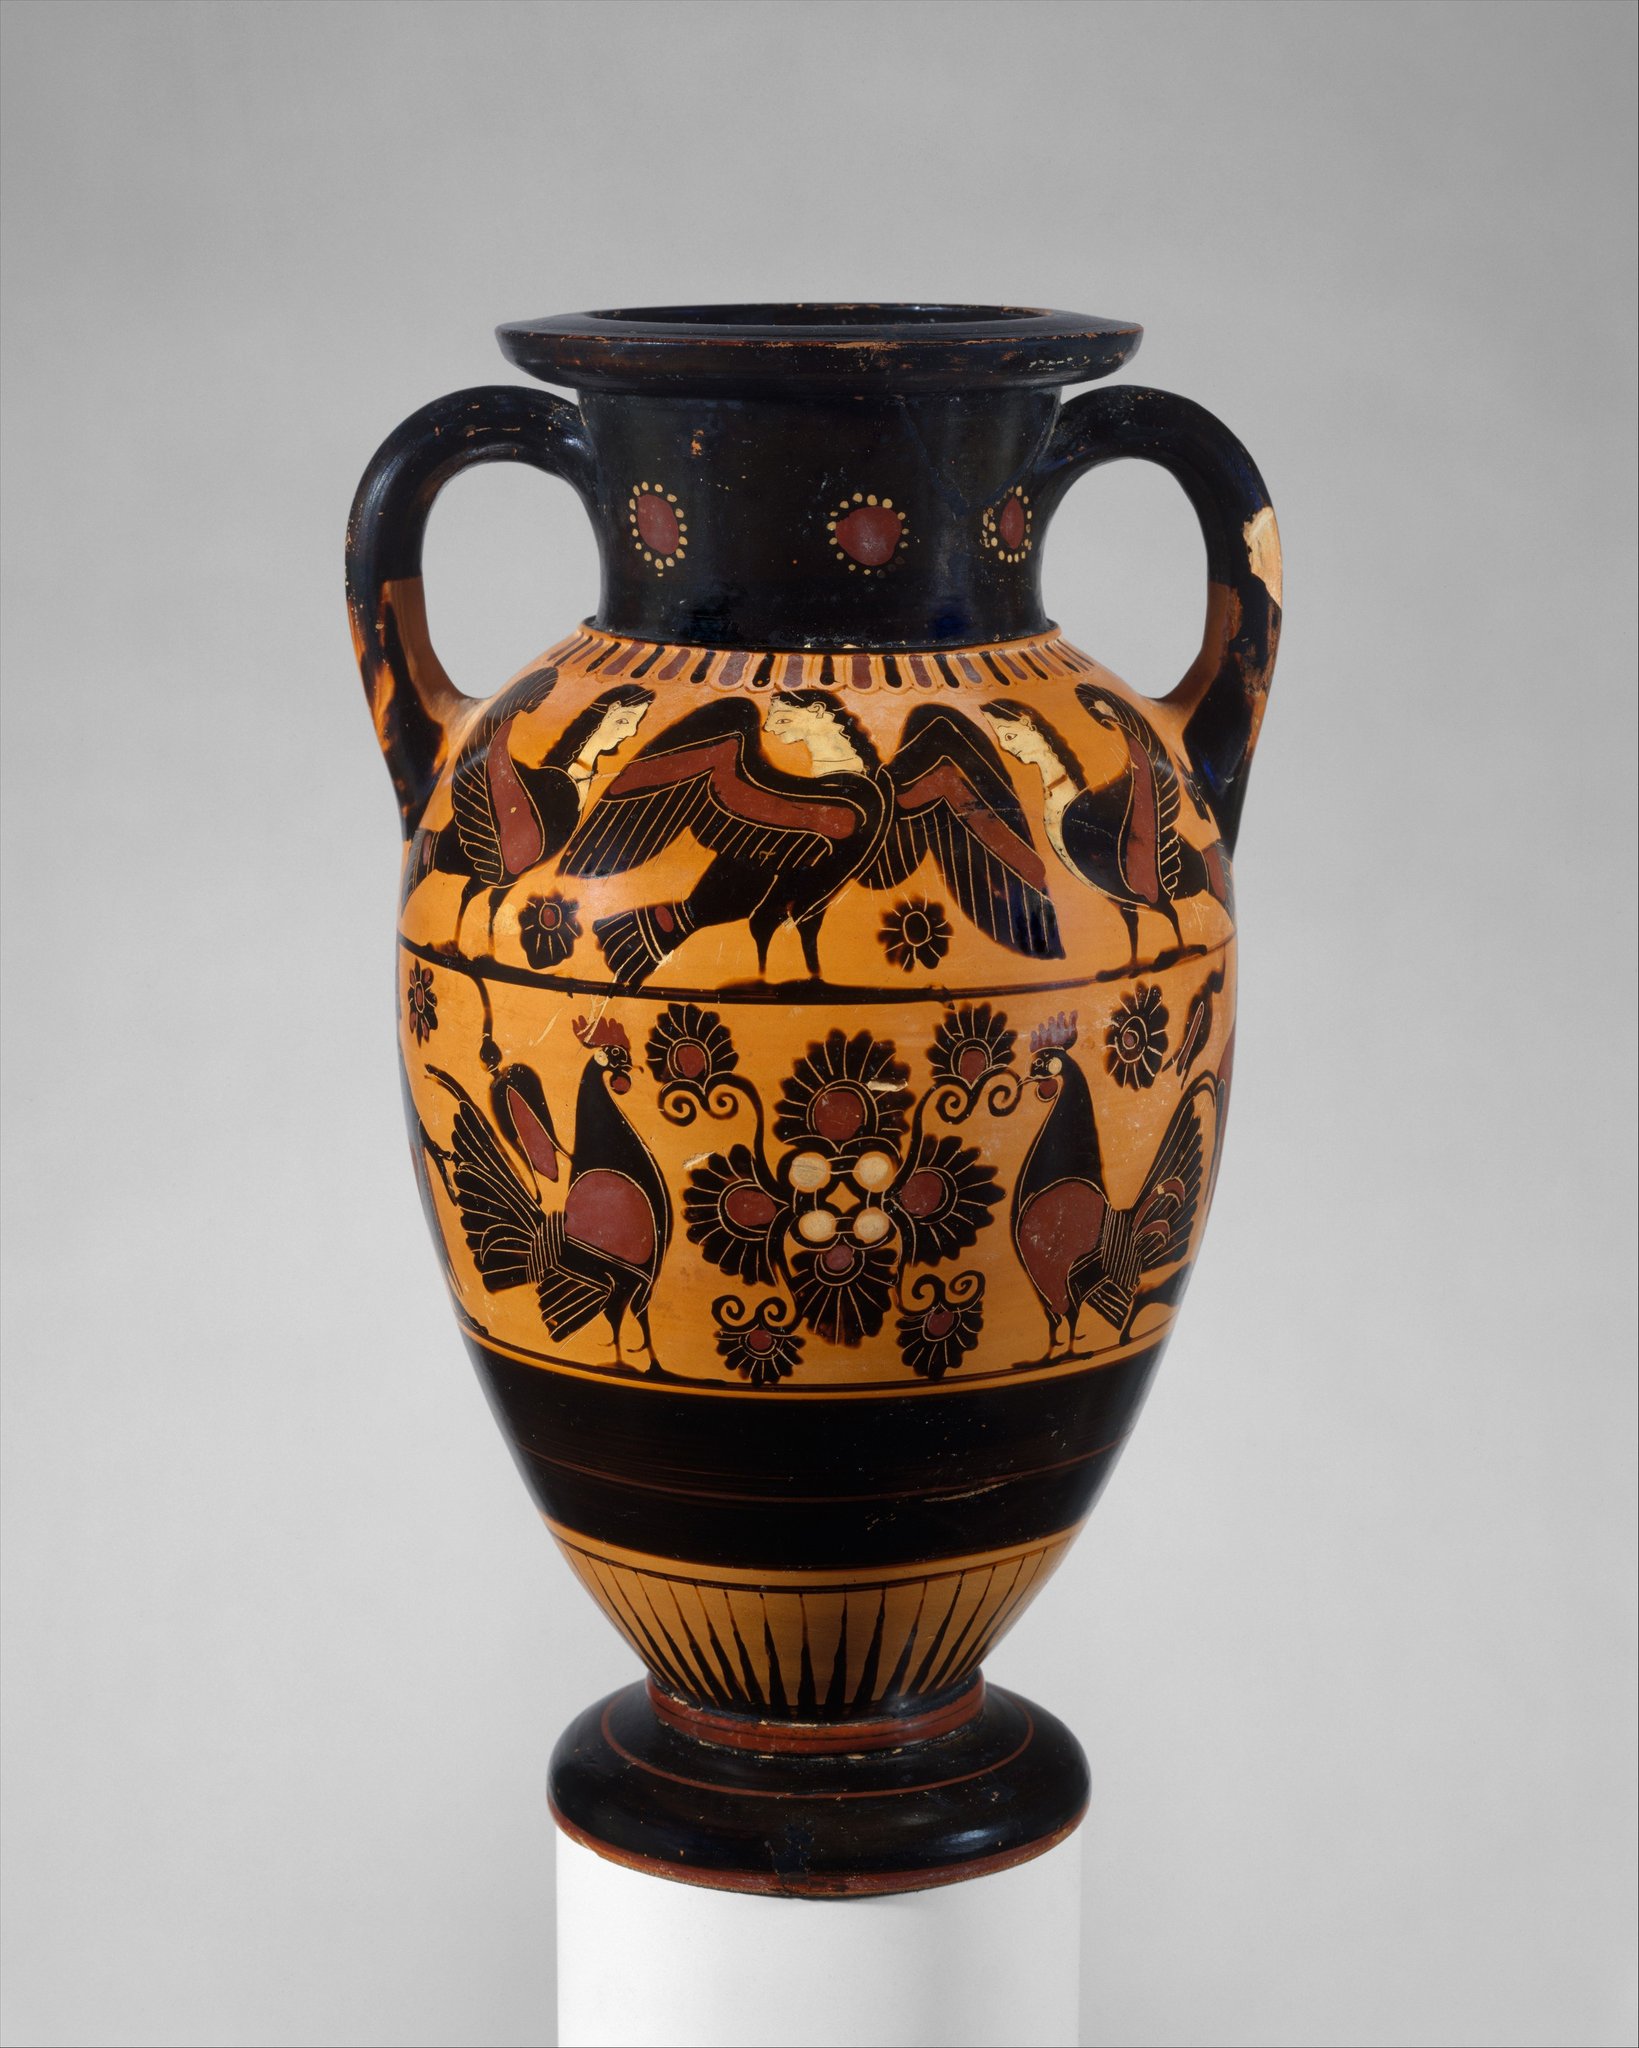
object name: neck amphora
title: Terracotta neck-amphora (jar)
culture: greek, chalcidian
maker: painter of the cambridge hydria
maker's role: artist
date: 540 BCE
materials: terracotta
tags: roosters,sirens